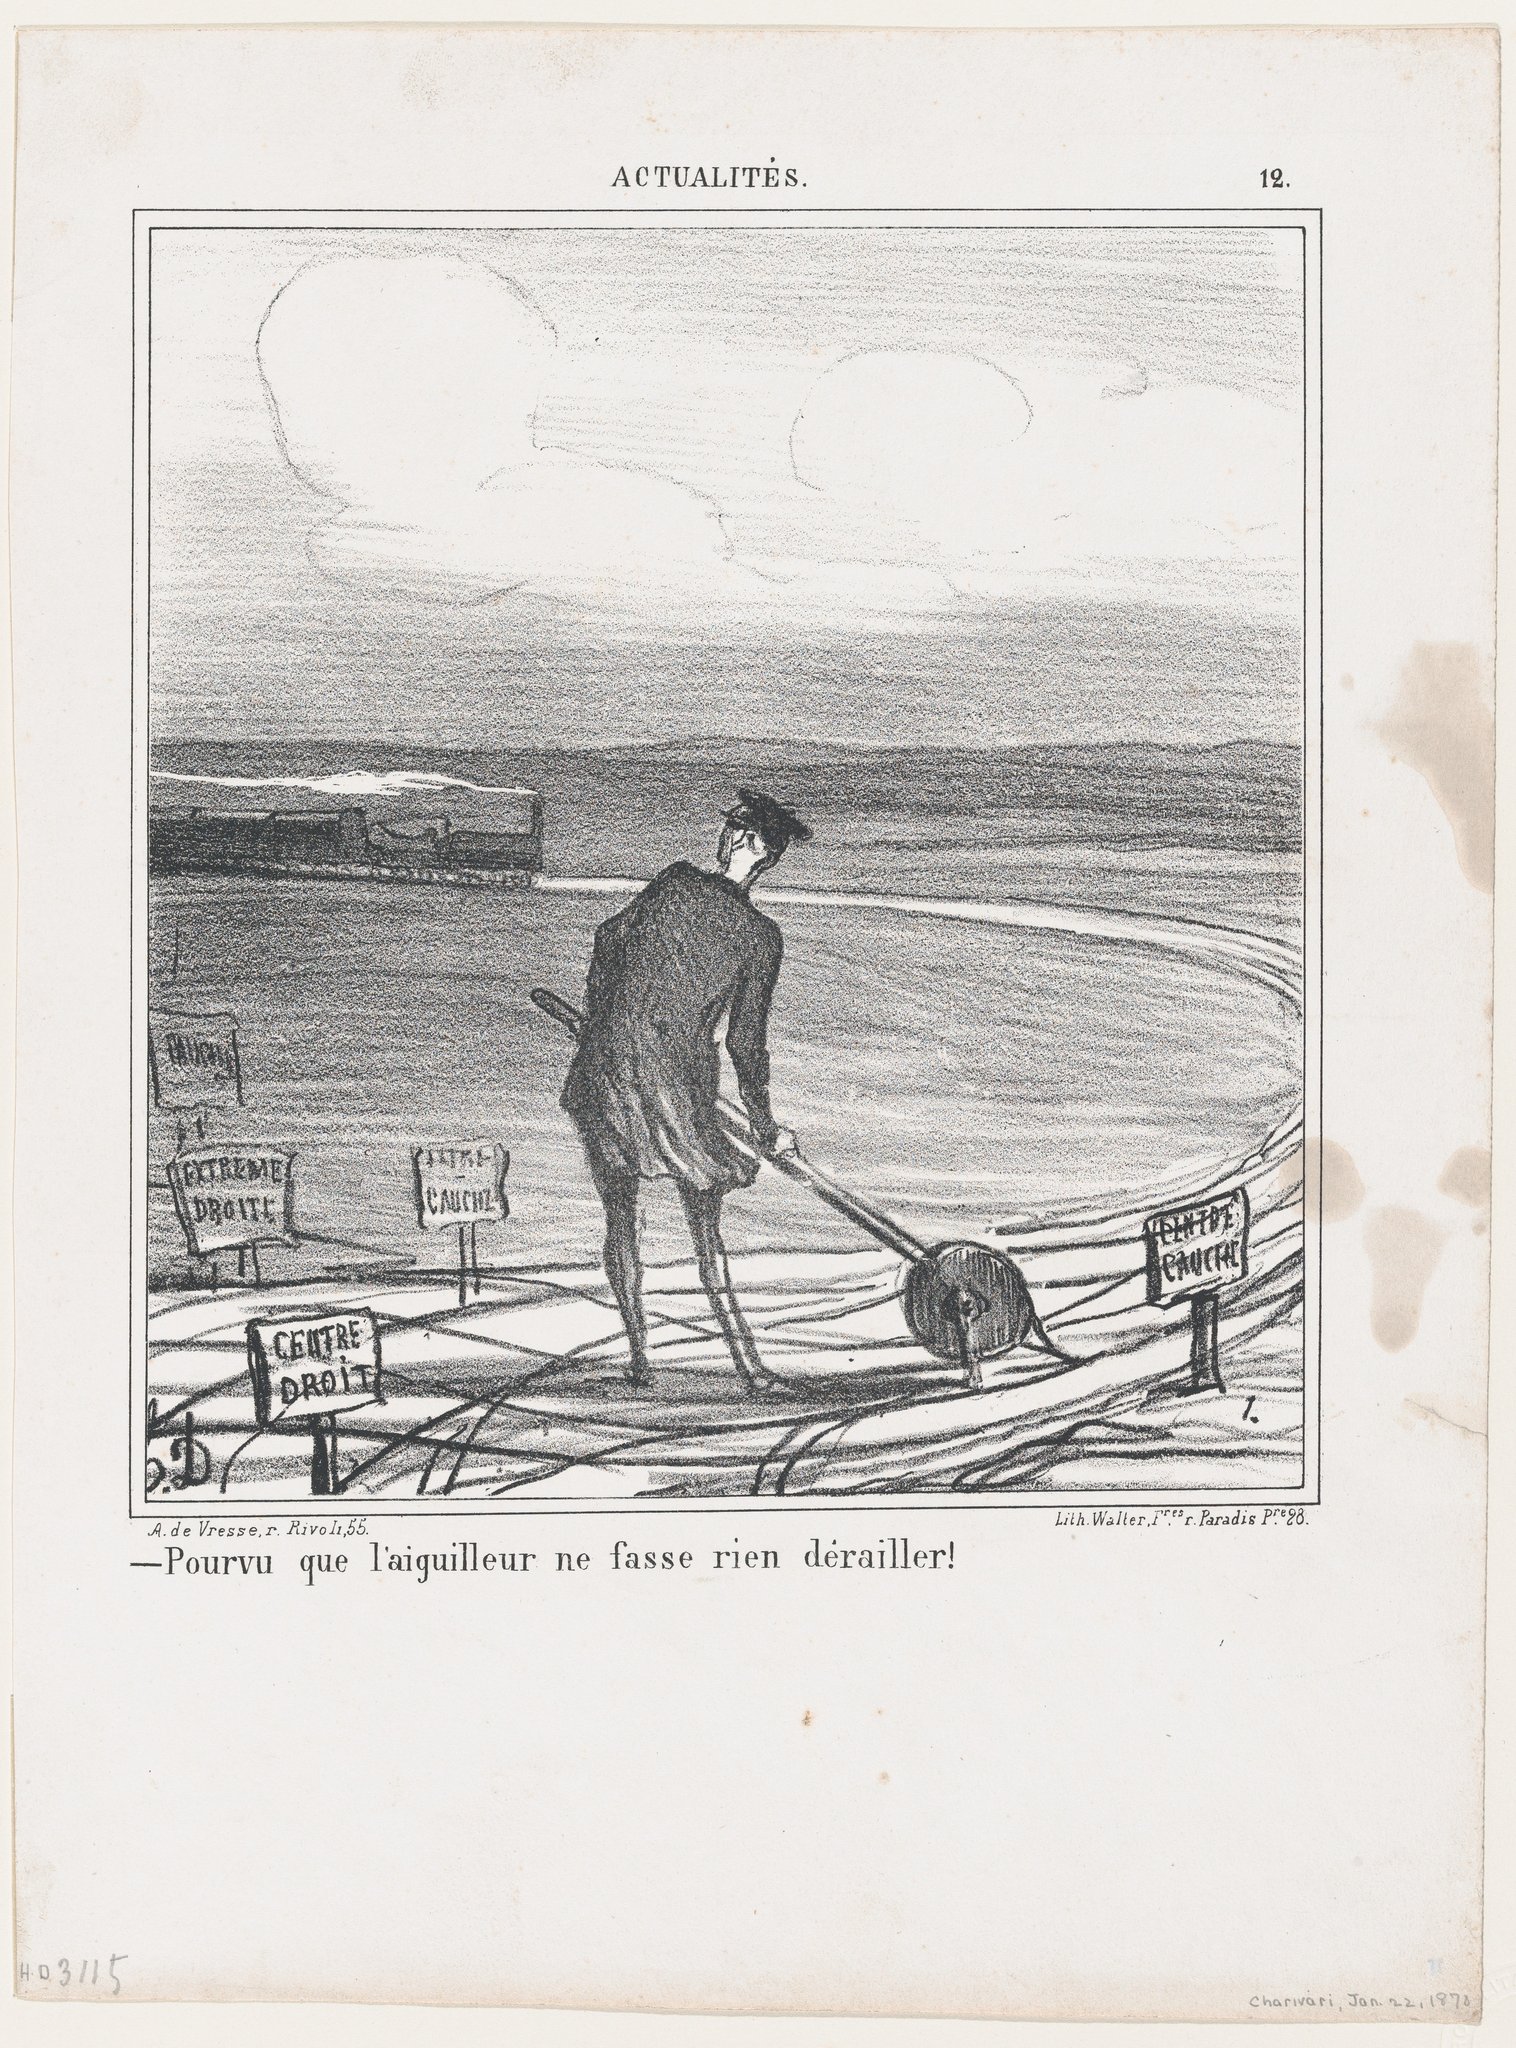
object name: print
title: Provided that the switchman lets nothing derail, from 'News of the day,' published in "Le Charivari"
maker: honoré daumier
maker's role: artist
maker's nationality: french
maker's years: 1808-1879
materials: paper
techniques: lithograph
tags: men,working